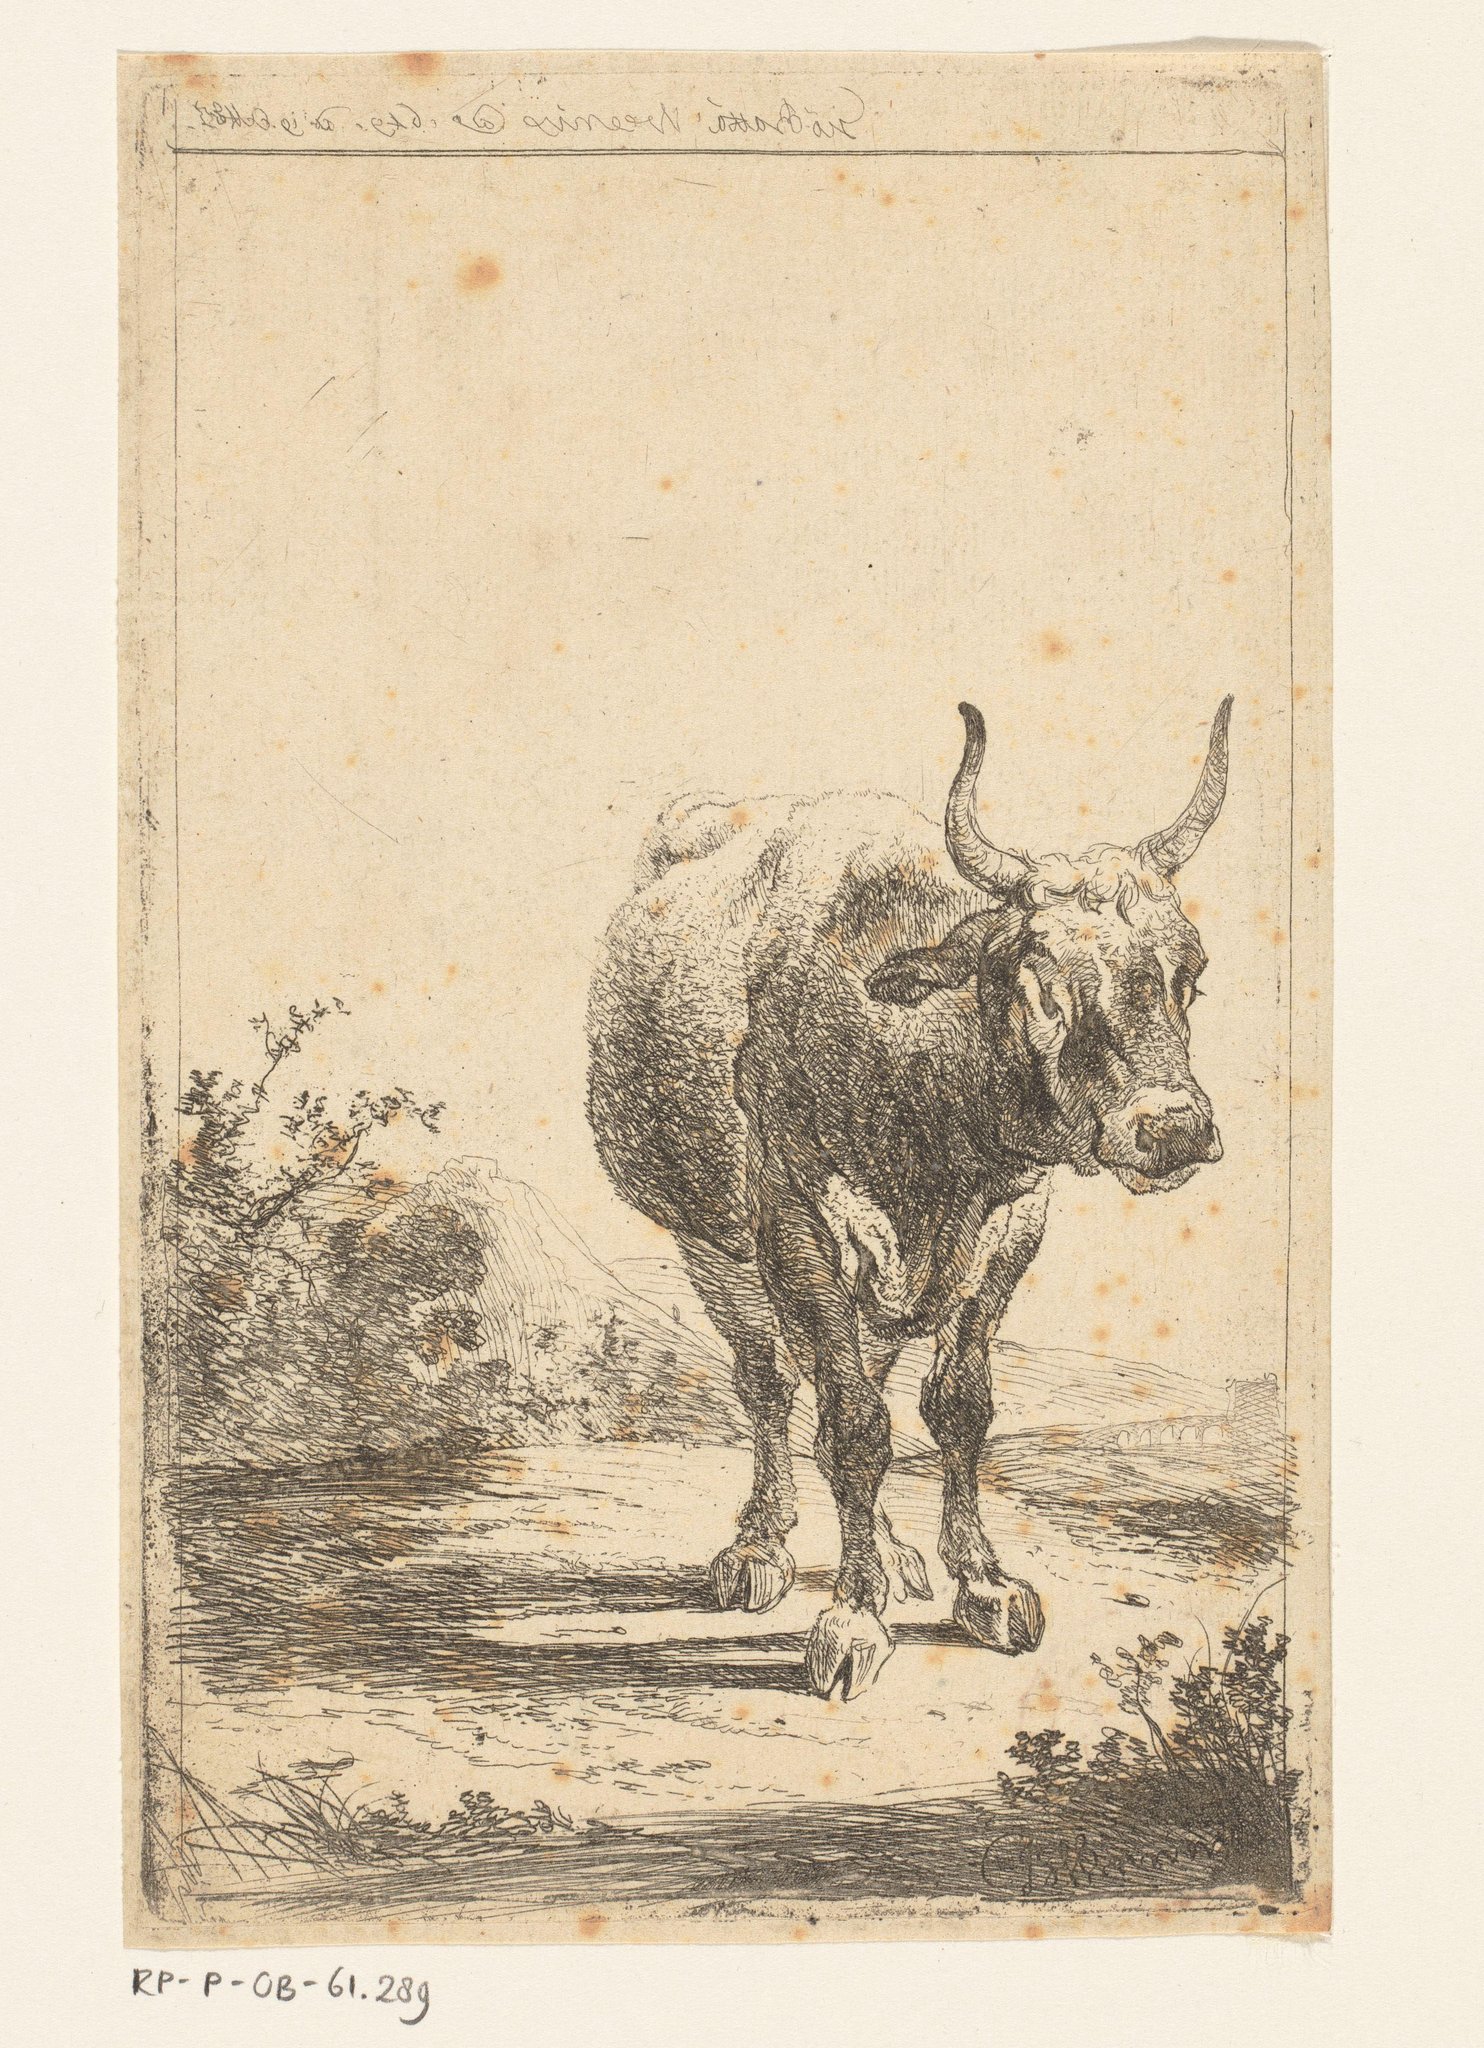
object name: print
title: Staande stier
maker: jan baptist weenix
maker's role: draughtsman, painter, print maker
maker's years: 1621-1661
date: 1647-1659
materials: paper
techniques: etching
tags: bull, landscapes, landscape with bridge, viaduct or aqueduct, aqueduct (~ water supply), mountains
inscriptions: collector's mark: Lugt 240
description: In een landschap staat een stier bij een struik. In de verte zijn links bergen en rechts een brug of aquaduct te zien.